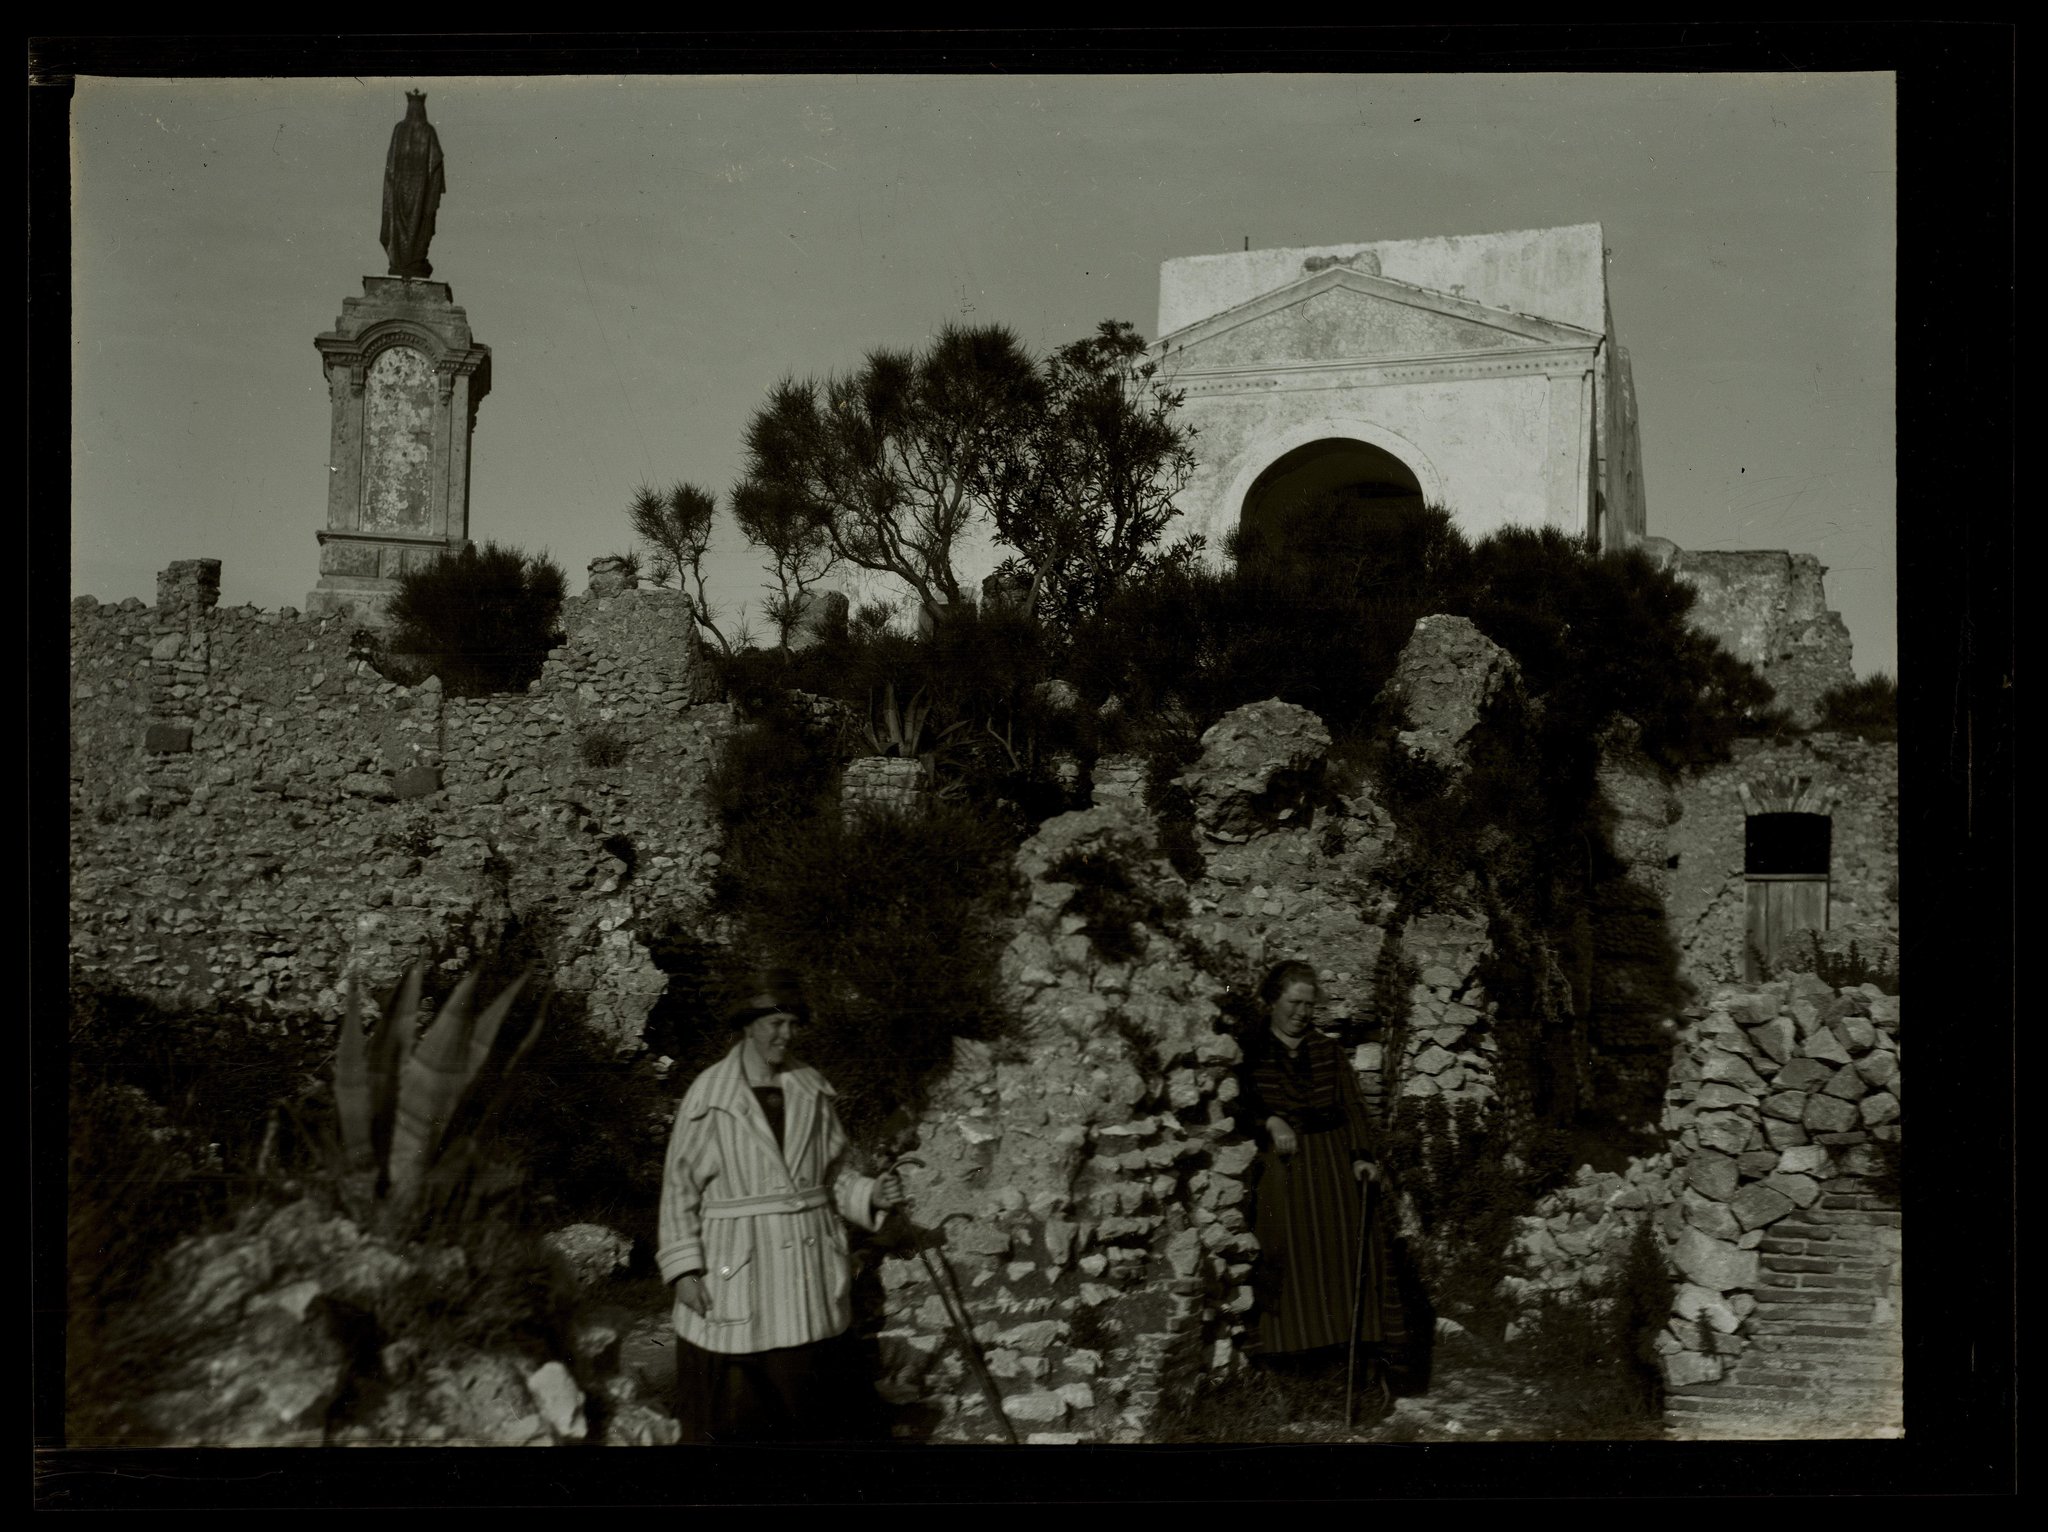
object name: negative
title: Filmnegatief met opname van Napels of omgeving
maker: Anonymous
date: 1907-1935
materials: film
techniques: gelatin silver negative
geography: italy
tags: italy